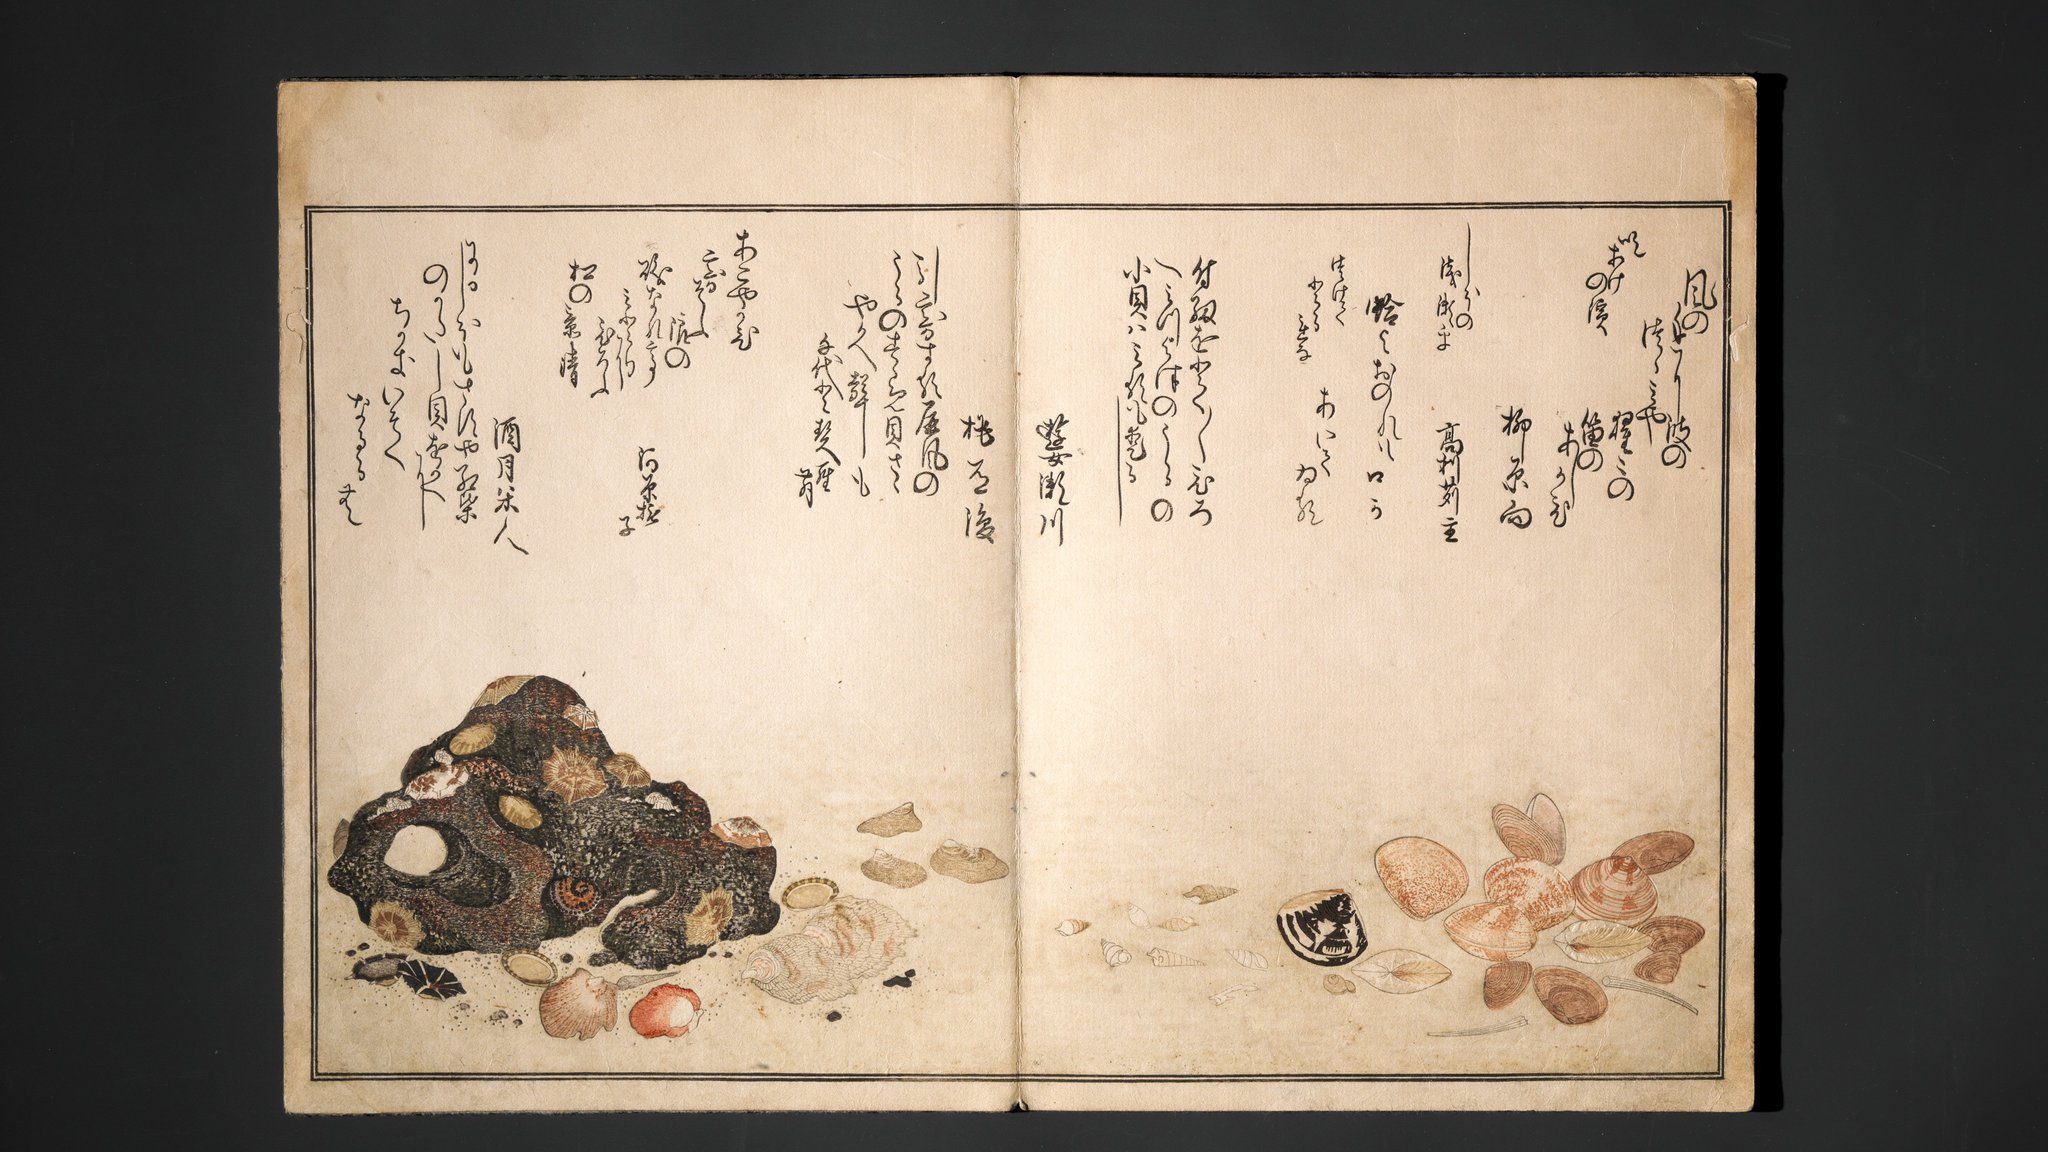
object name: illustrated book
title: Gifts of the Ebb Tide (The Shell Book) (Shiohi no tsuto) 潮干のつと(都登)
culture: japanese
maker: kitagawa utamaro 喜多川歌麿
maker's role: artist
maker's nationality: japanese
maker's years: 1754-1806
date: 1789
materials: gold leaf, ink, mica, paper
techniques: woodblock print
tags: women,shells